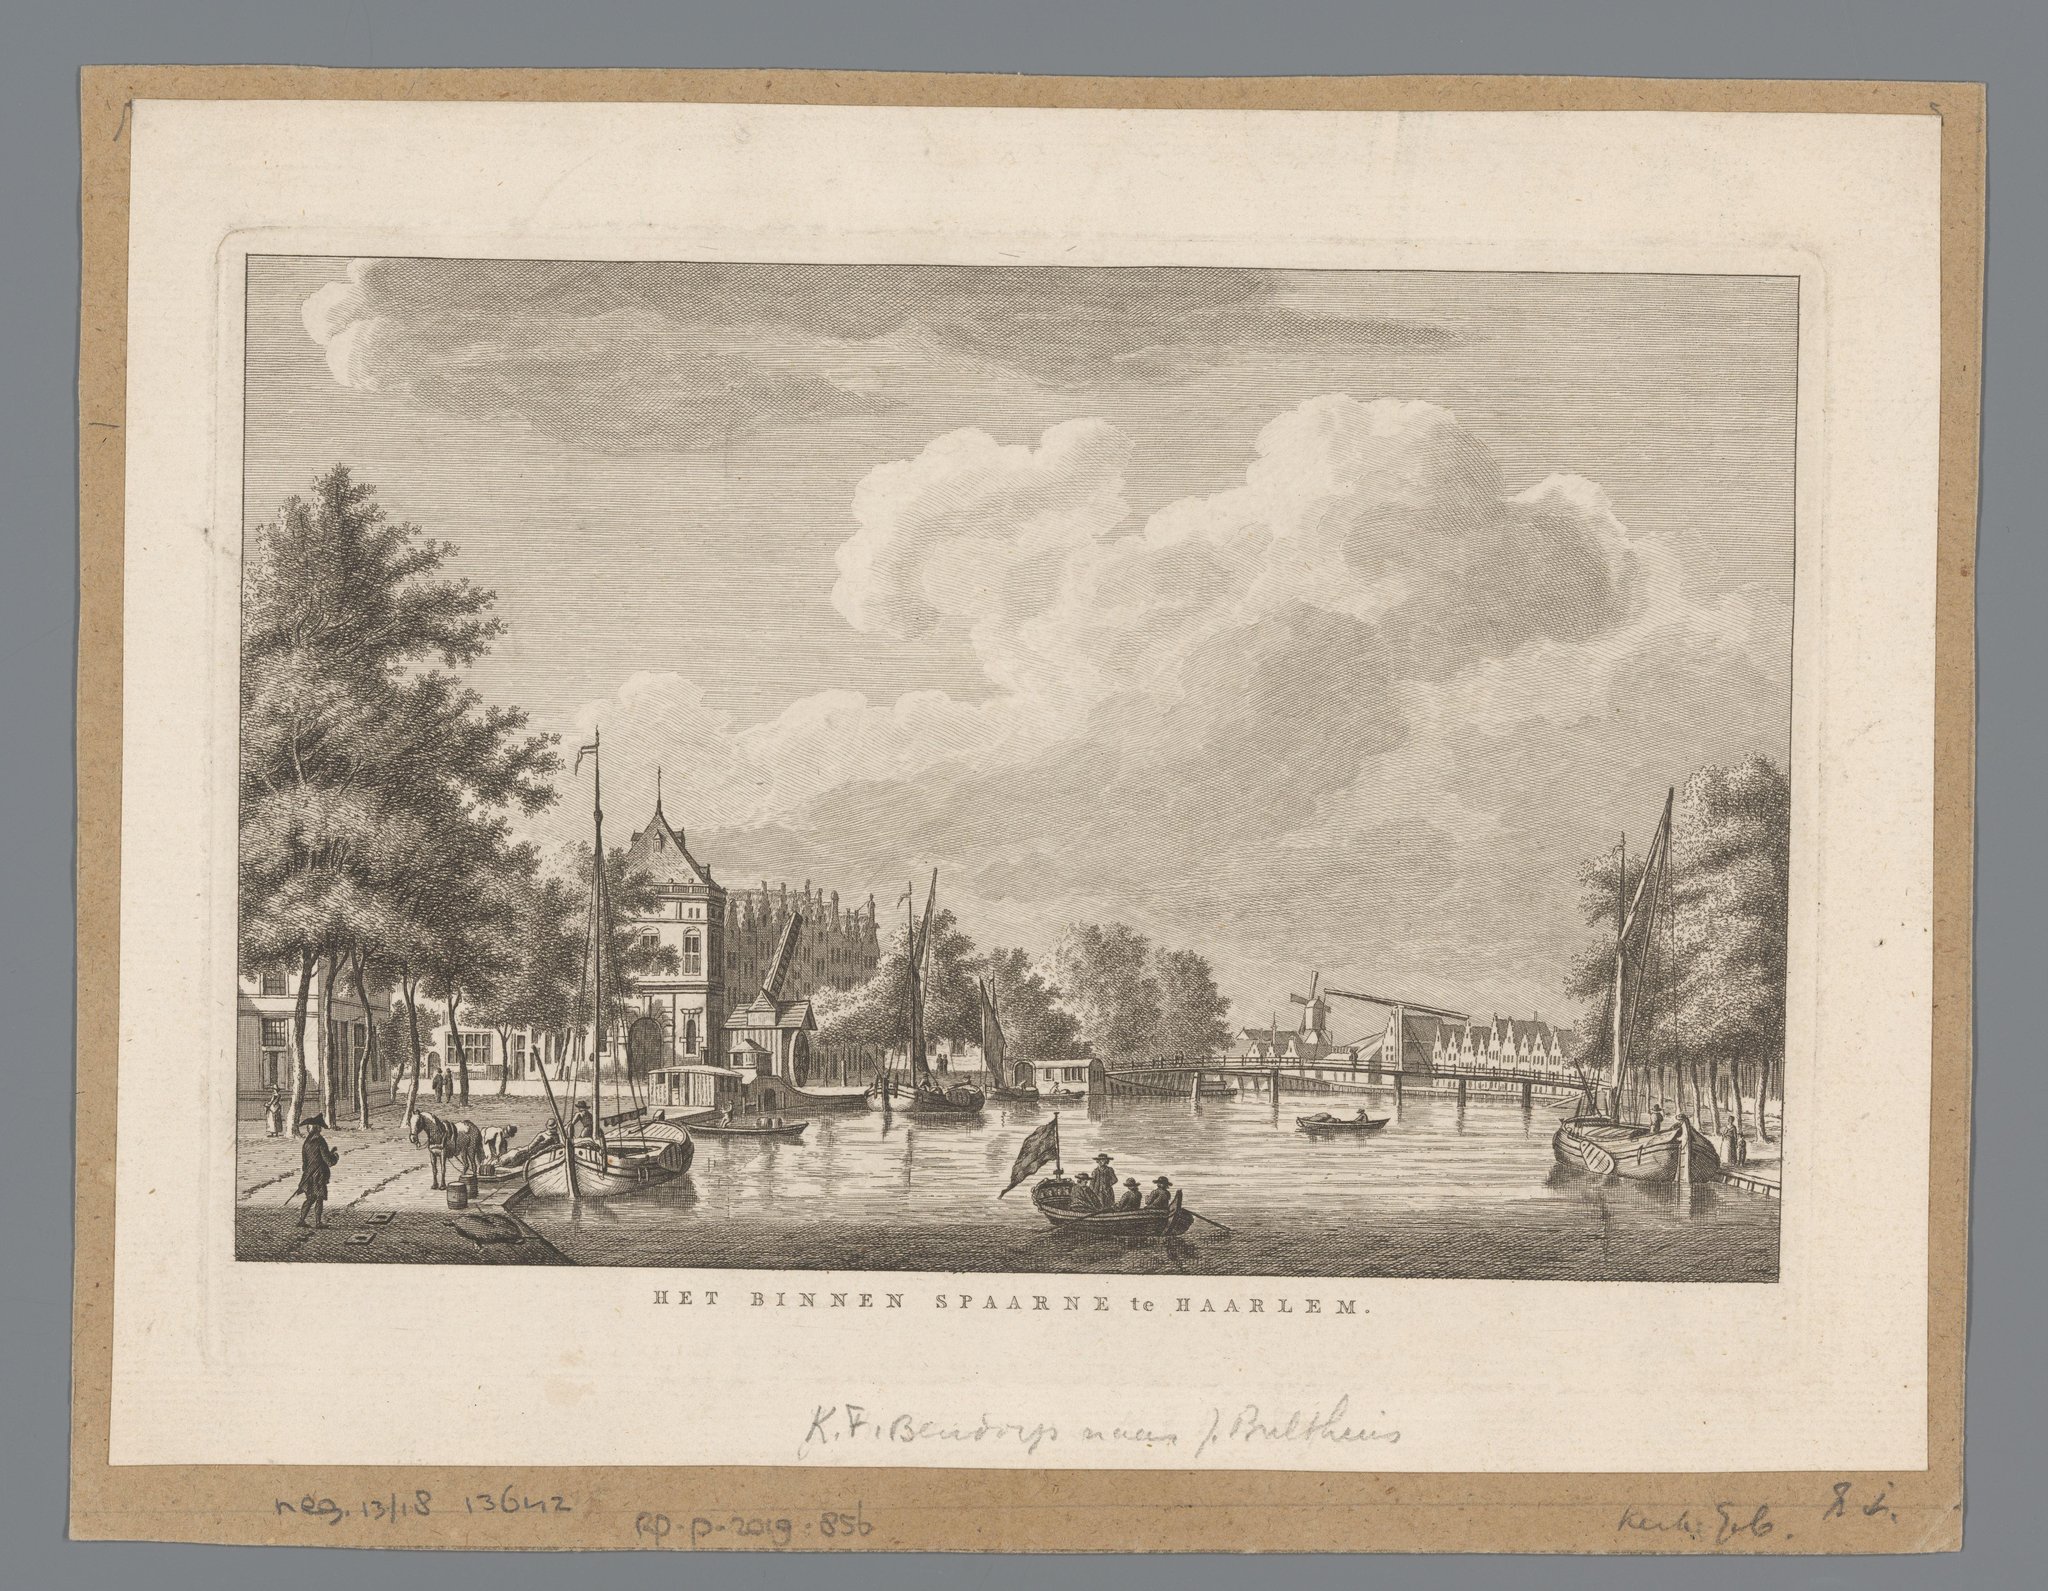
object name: print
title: Stadsgezicht met het Spaarne en Waag in Haarlem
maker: carel frederik bendorp (i)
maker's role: print maker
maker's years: 1736-1814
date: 1786-1792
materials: paper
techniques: etching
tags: sailing-ship, sailing-boat, rowing-boat, canoe, etc., bridge in city across river, canal, etc., windmill, weigh-house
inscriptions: collector's mark: Lugt 2228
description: Prent uit: Vaderlandsche gezichten, of afbeeldingen van den tegenwoordigen staat der Vereenigde Nederlanden (…). Amsterdam: Hendrik Gartman, Willem Vermandel en Jan Willem Smit, 1786-1792. Uitgegeven in afleveringen met ieder een eigen bifolium en inhoudsopgave. Alle prenten in deze publicatie zijn gegraveerd door Carel Frederik Bendorp (I) en, in de meeste gevallen, gebaseerd op tekeningen van Jan Bulthuis.